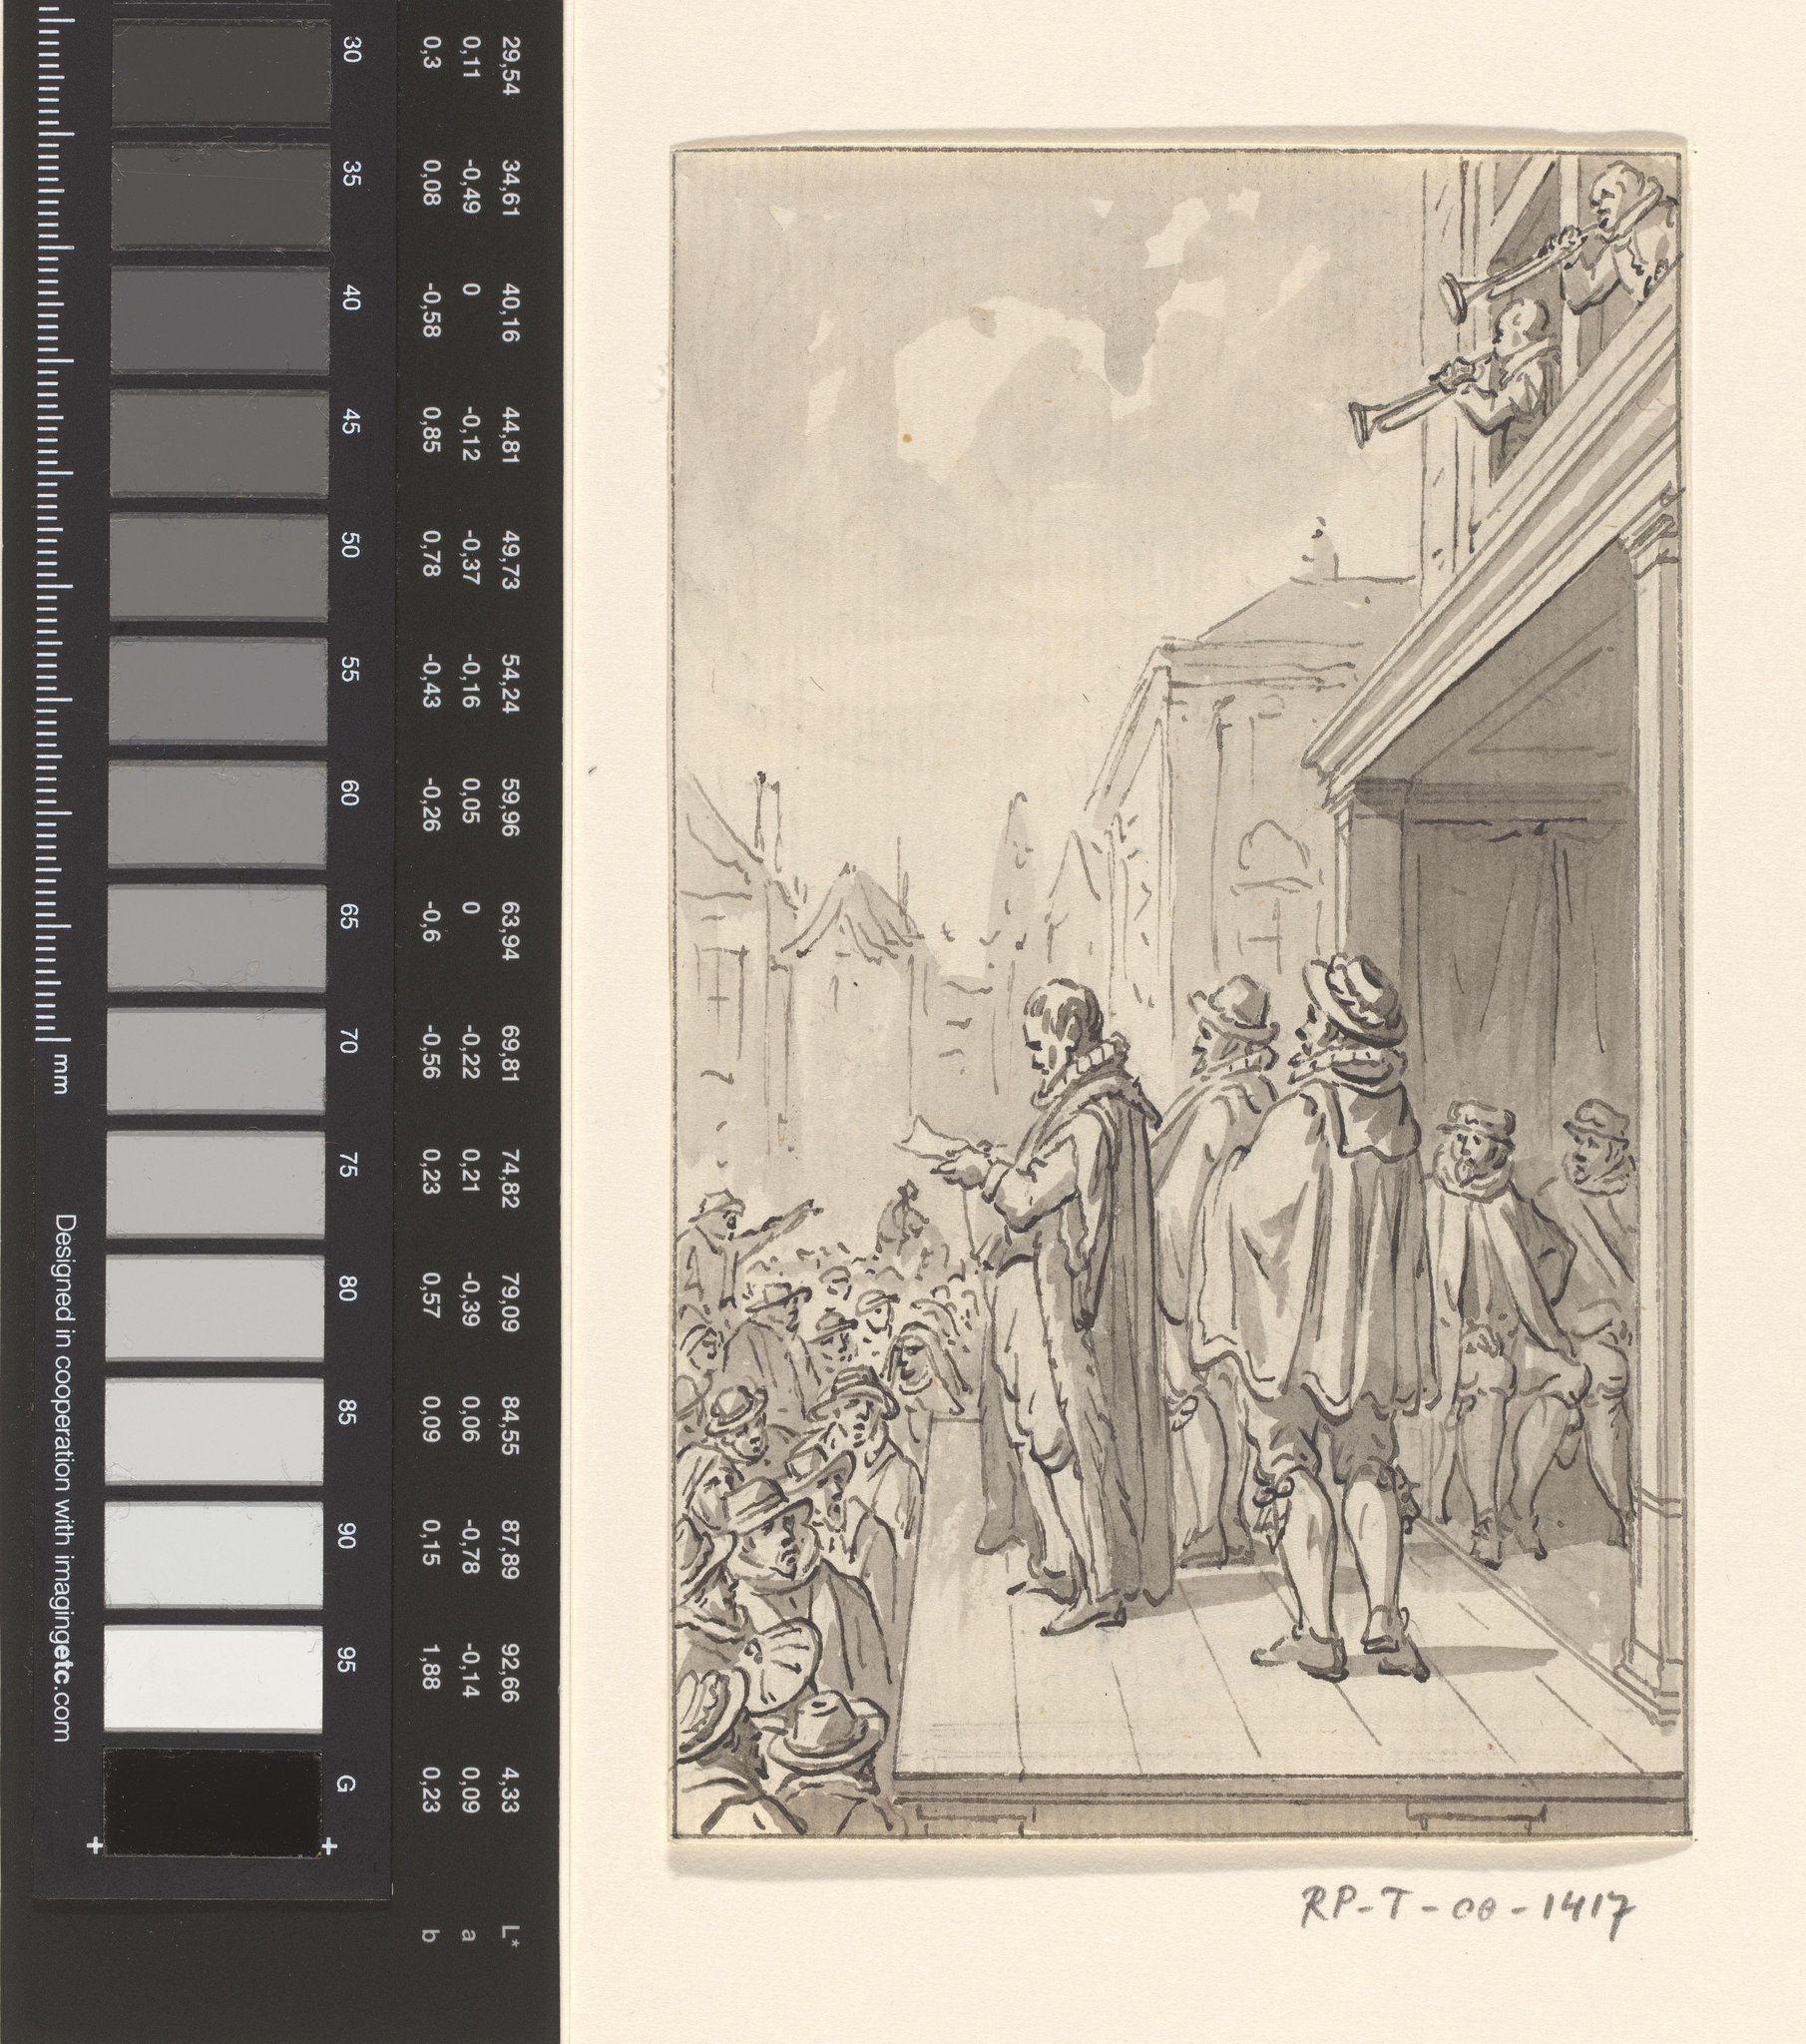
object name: drawing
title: Afkondiging van de Pacificatie van Gent, 1576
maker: jacobus buys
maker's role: draughtsman, print maker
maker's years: 1724-1801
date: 1785-1787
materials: ink, paper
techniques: brush, pen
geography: netherlands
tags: proclamation of peace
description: Bekendmaking van het ondertekenen van de Pacificatie van Gent op 8 november 1576. Op een stellage wordt aan het aanwezige publiek de vrede bekend gemaakt en voorgelezen. Uit de ramen blazen twee mannen op bazuinen. Ontwerp voor een prent.